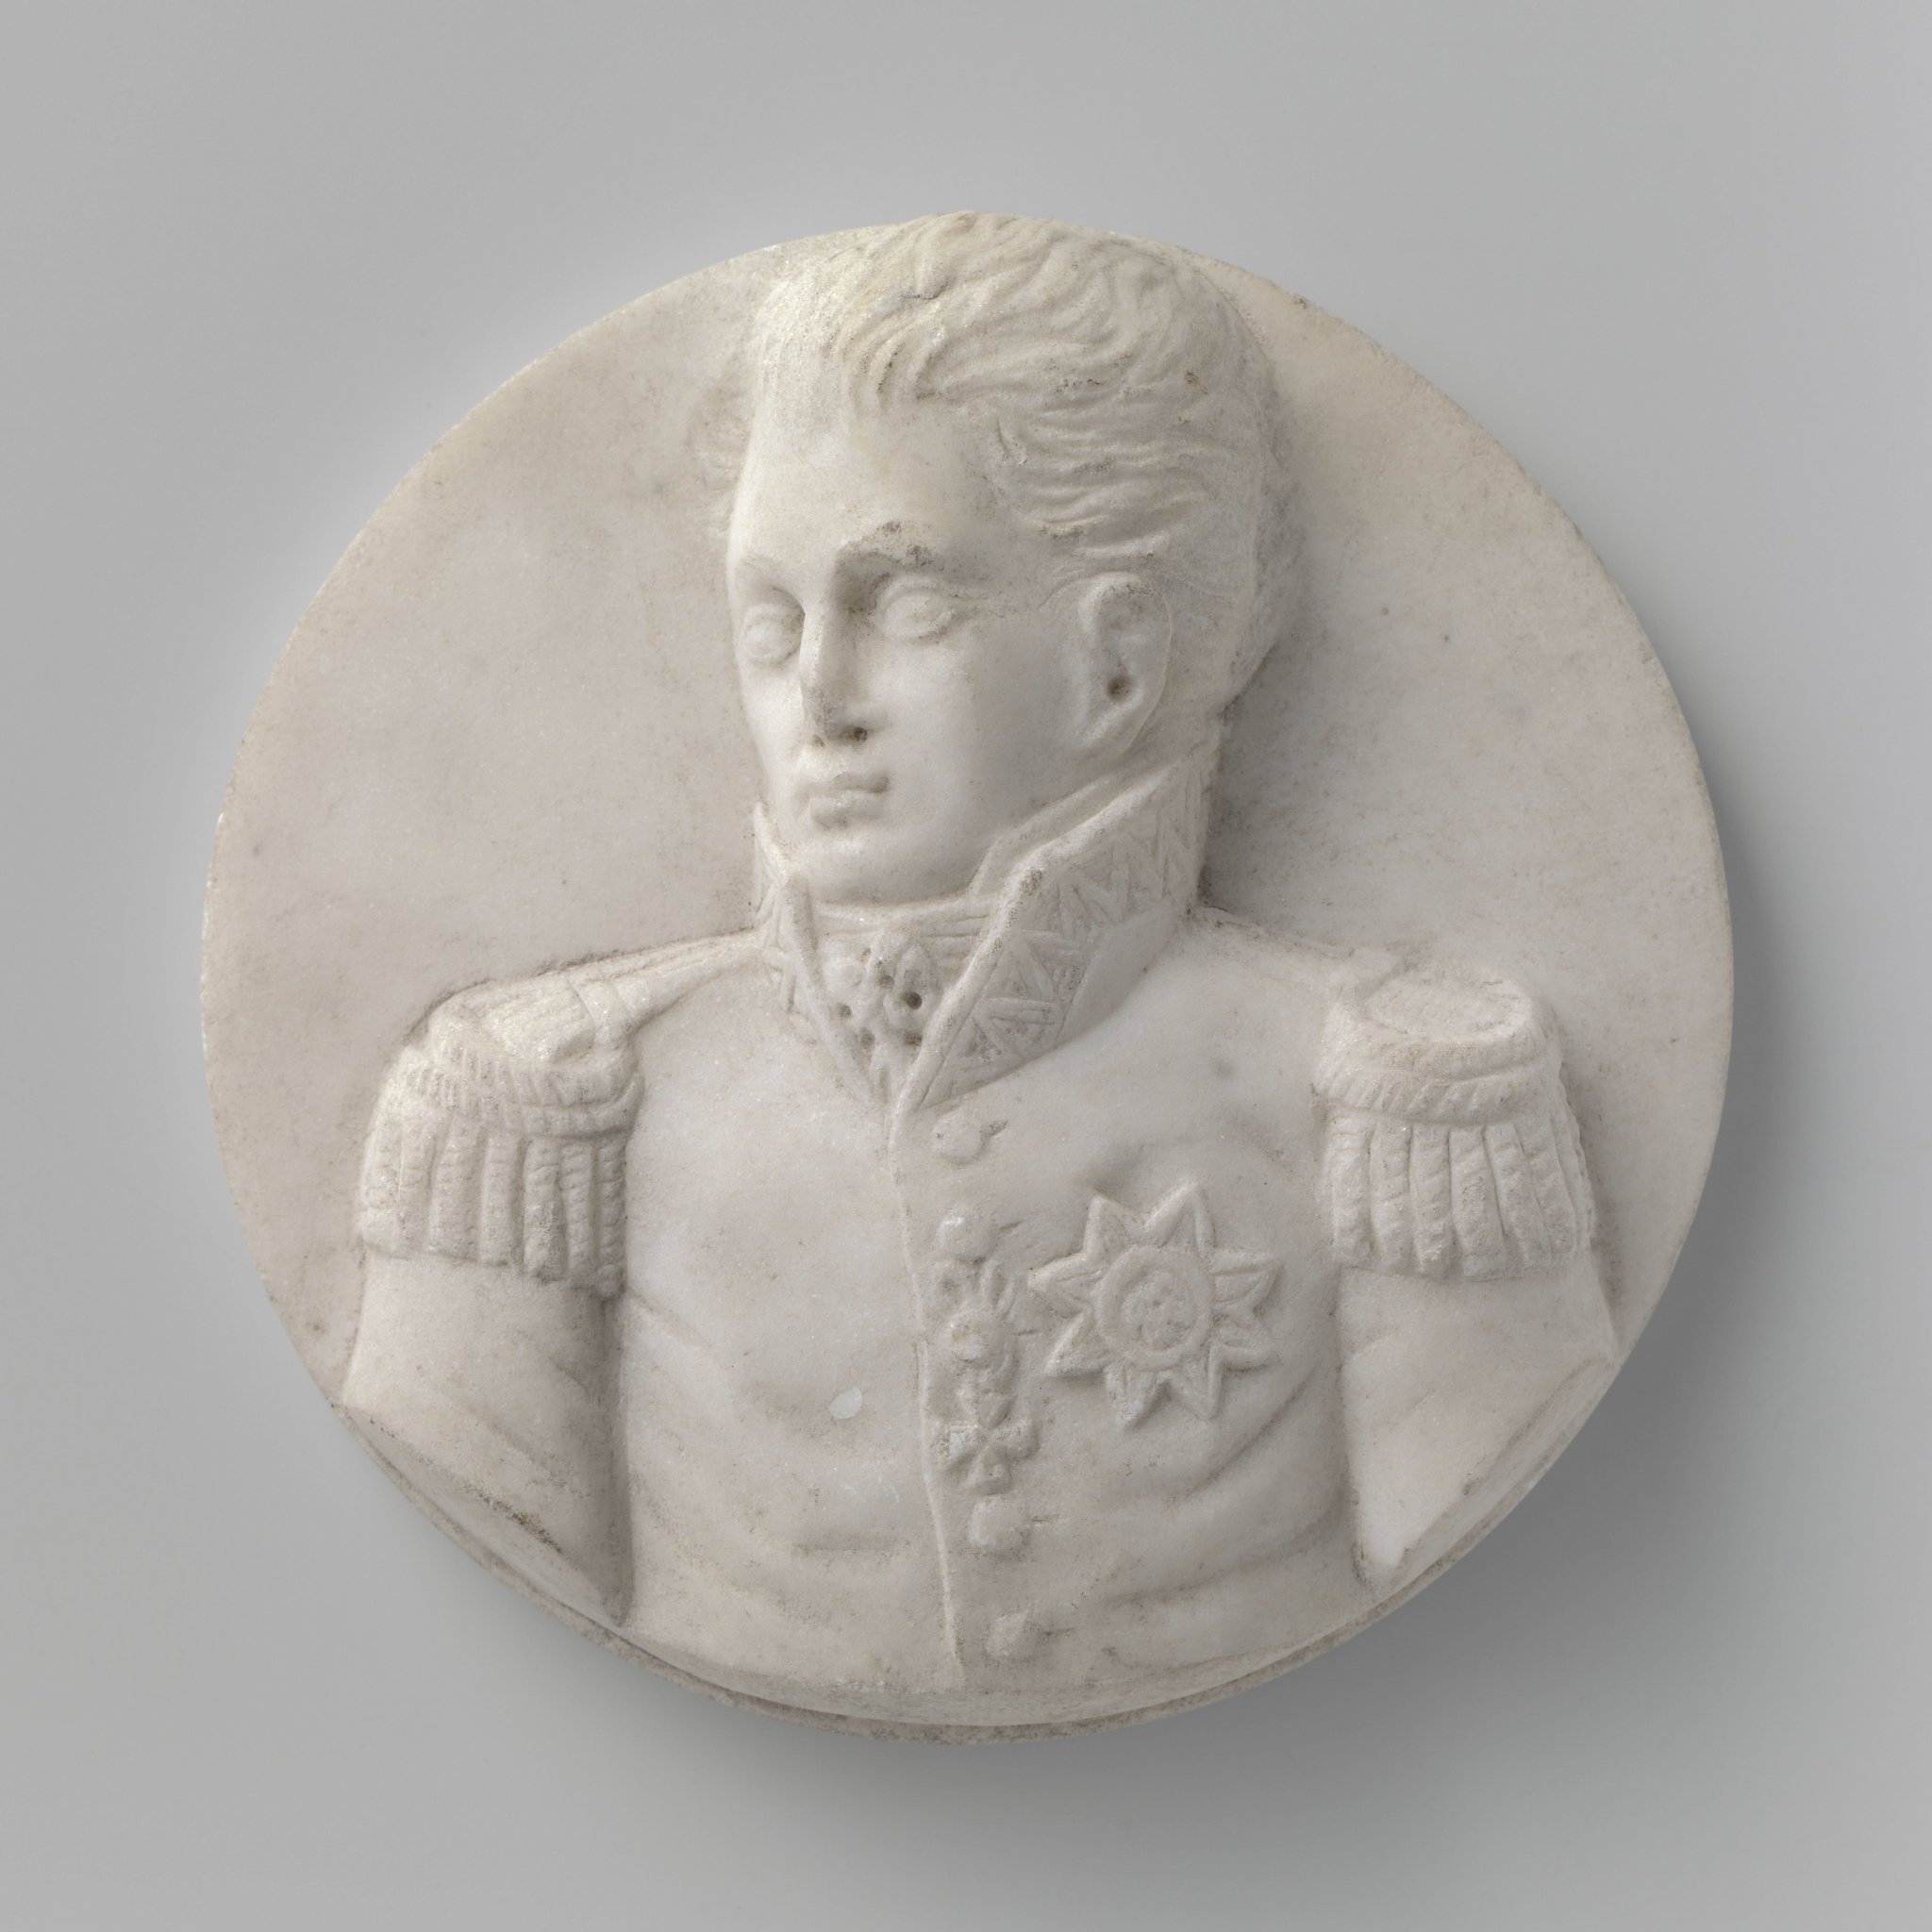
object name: sculpture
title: Medaillonportret van prins Frederik Willem Karel (1797-1881)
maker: Anonymous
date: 1810-1815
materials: marble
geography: netherlands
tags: frederik (prins der nederlanden)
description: Marmeren reliëf met het portret van prins Frederik Willem Karel (1797-1881). De jongste zoon van koning Willem I is driekwart naar links afgebeeld.